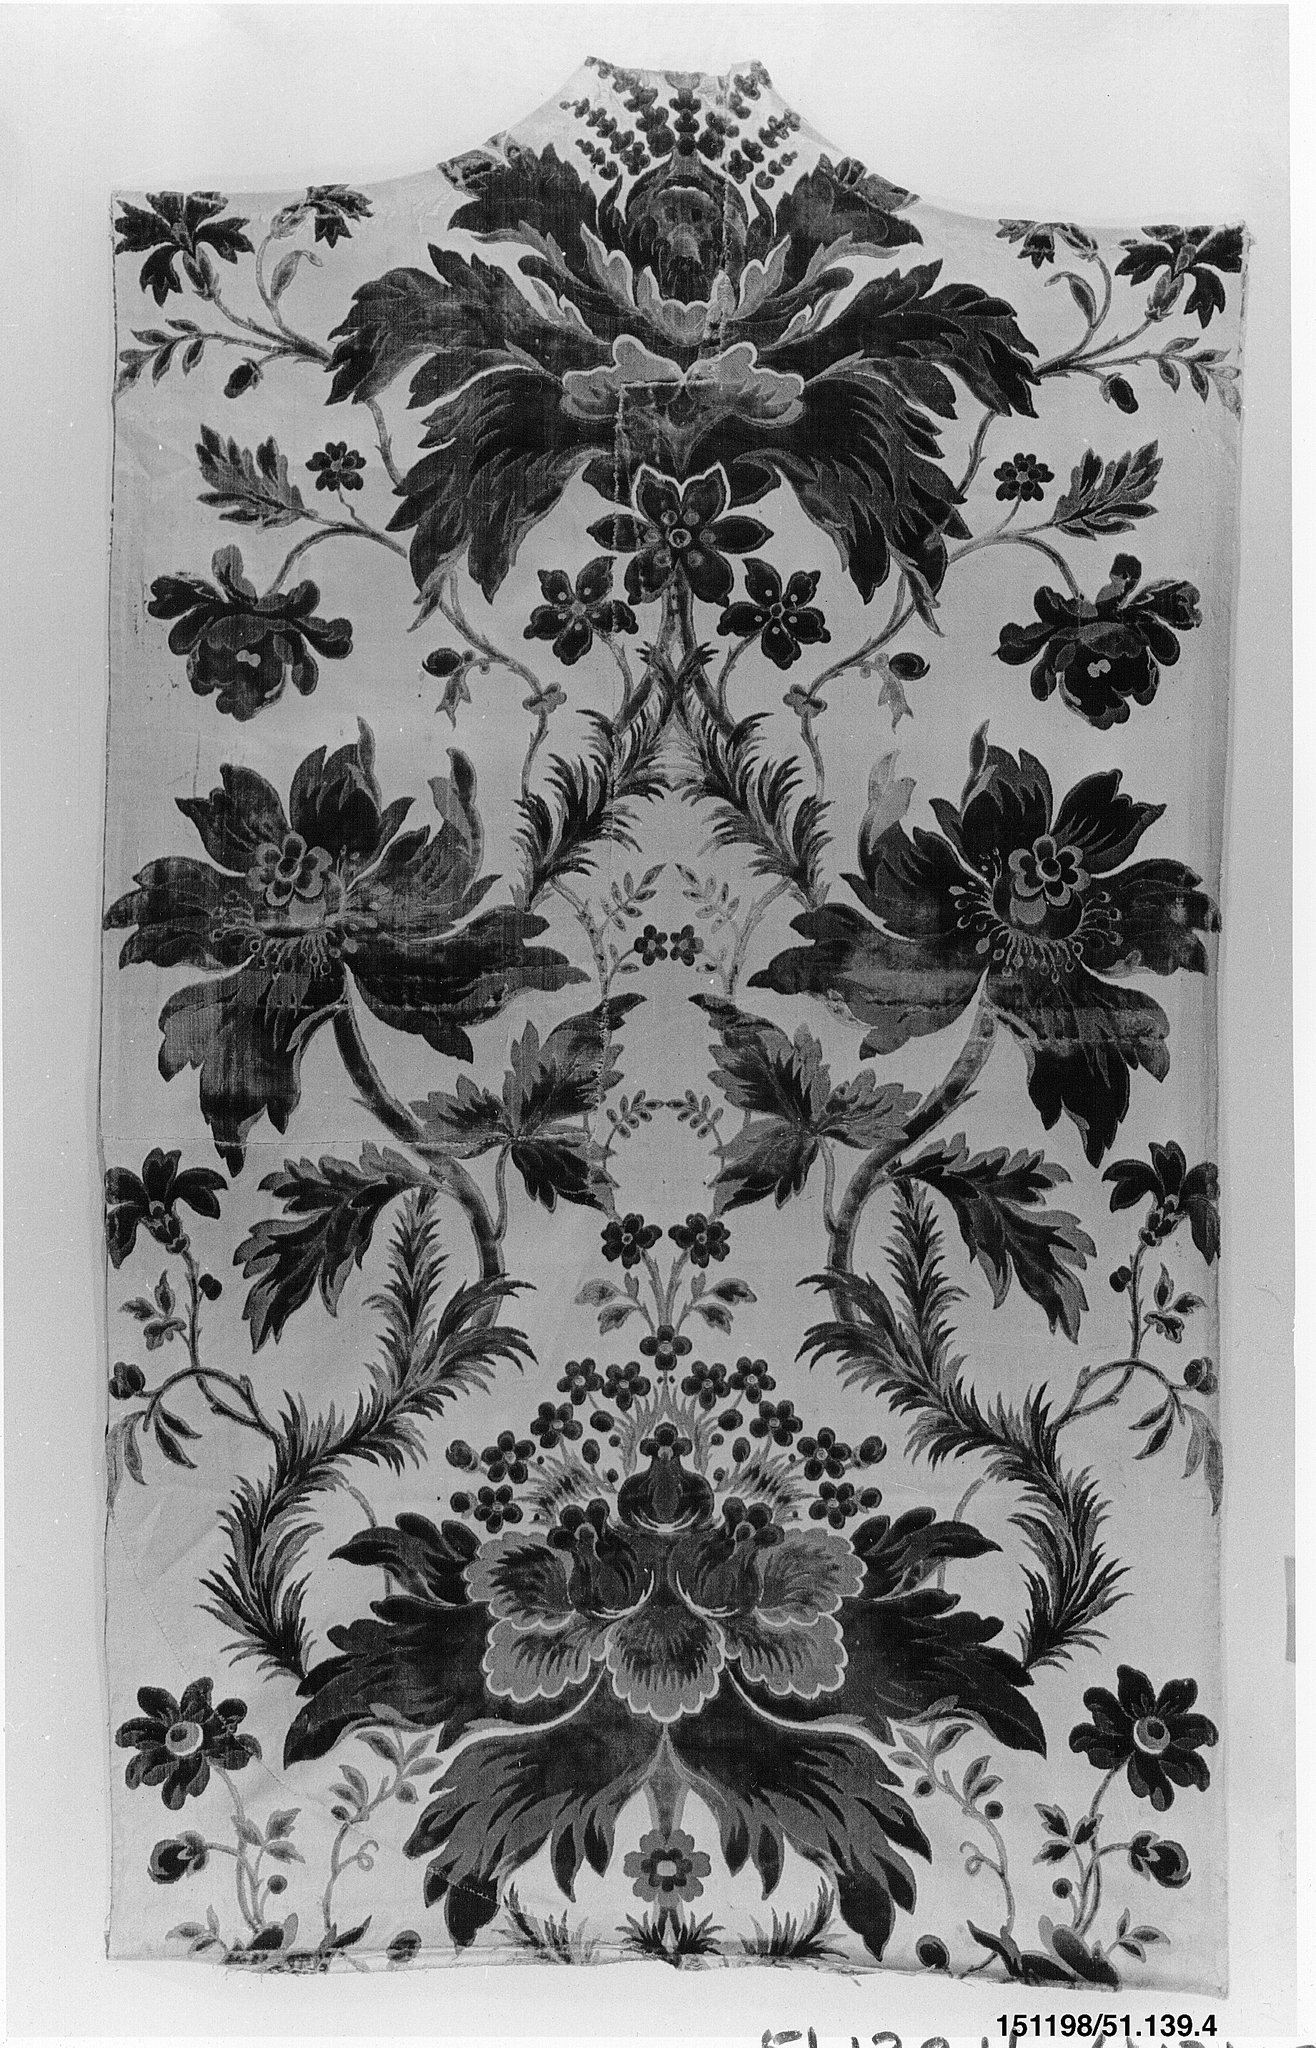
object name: piece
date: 1745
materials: silk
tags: flowers,leaves